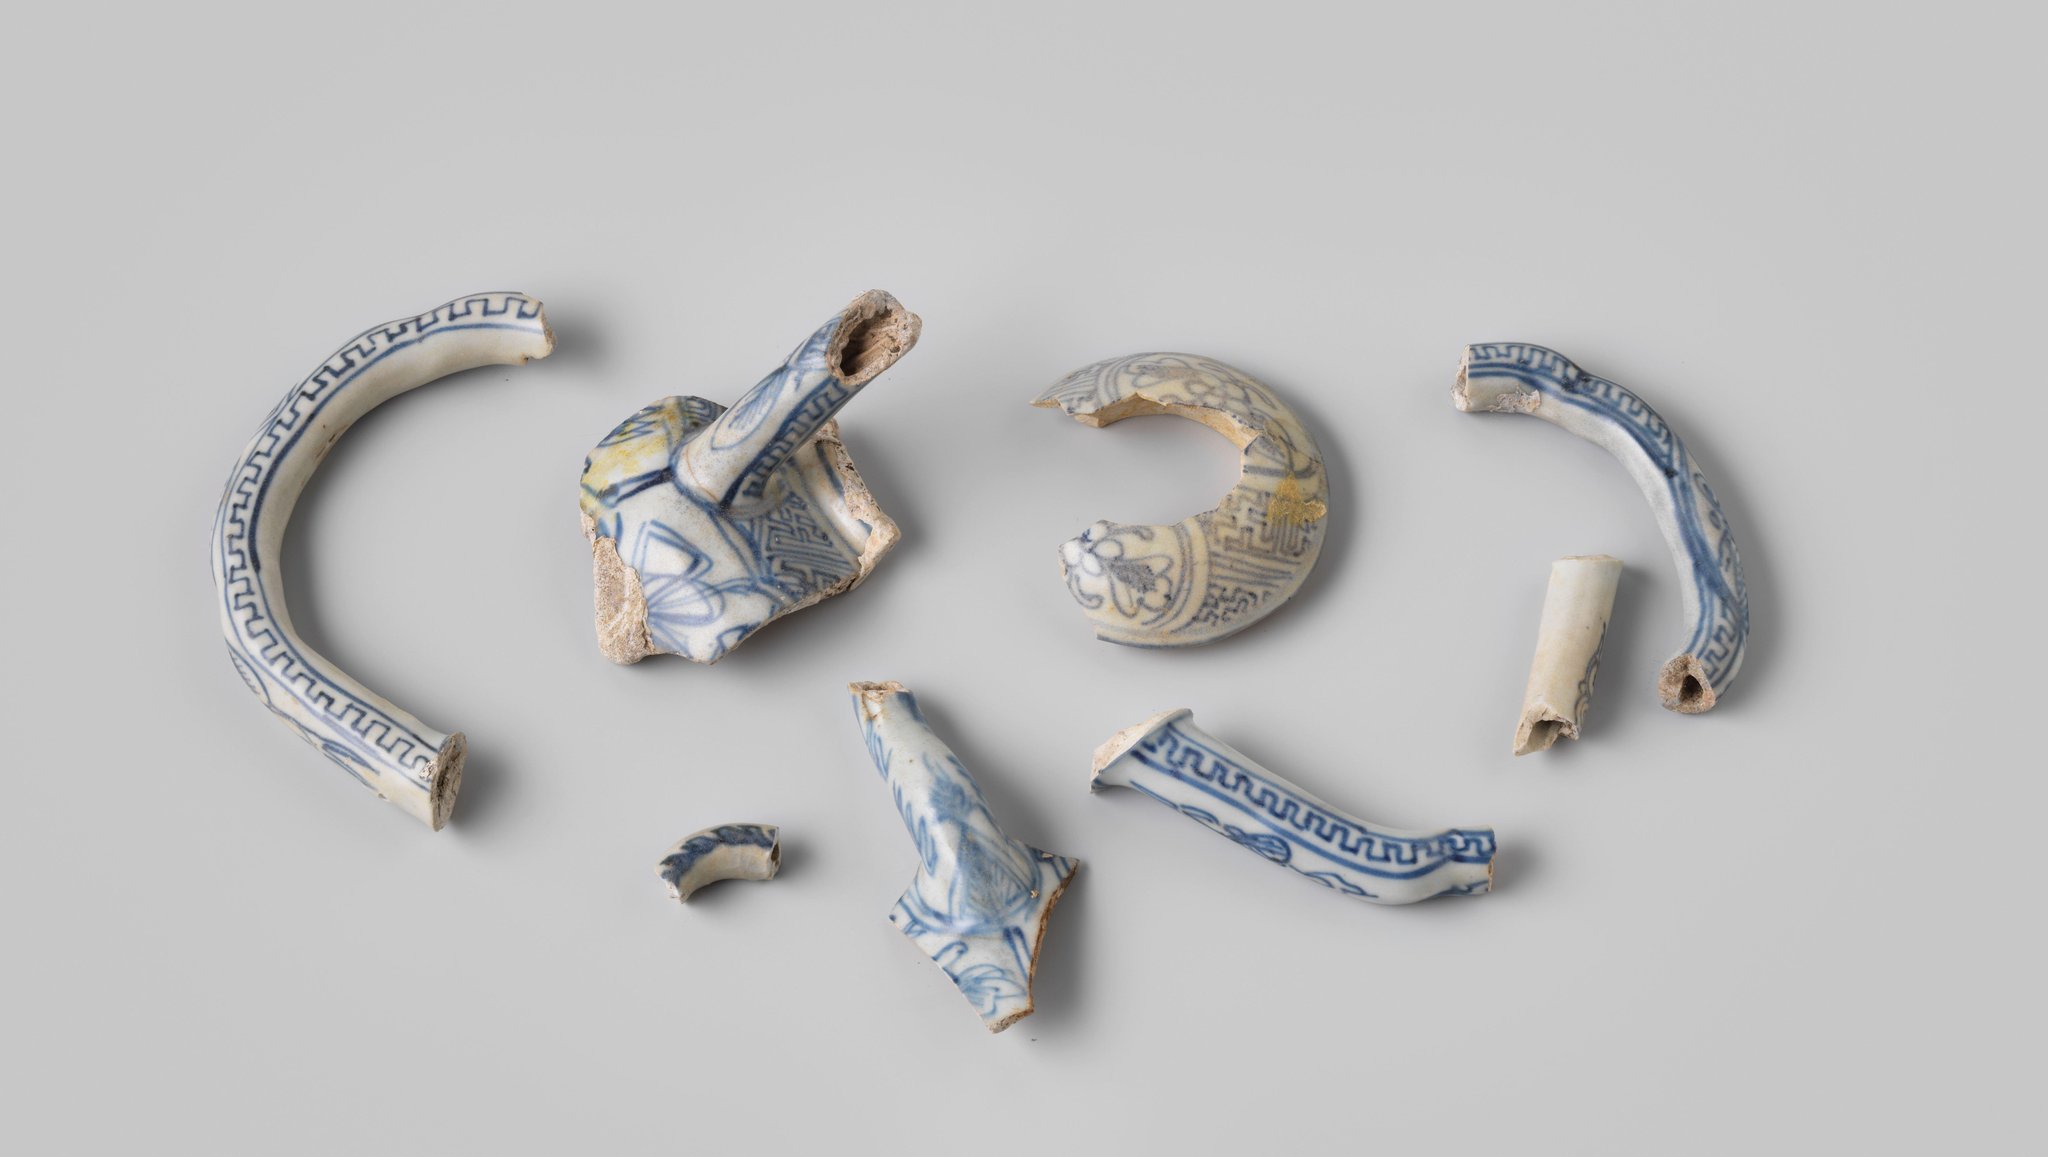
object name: sherd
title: Porseleinen scherven uit V.O.C.-schip de 'Witte Leeuw'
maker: Anonymous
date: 1613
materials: bone china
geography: jingdezhen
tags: verenigde oostindische compagnie, sint-helena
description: A kendi with a rounded side. Decorated with birds and flowers under a band with diaper patterns. The neck decorated with plantain leaves, the spout with peaches and groups of dots in sections.